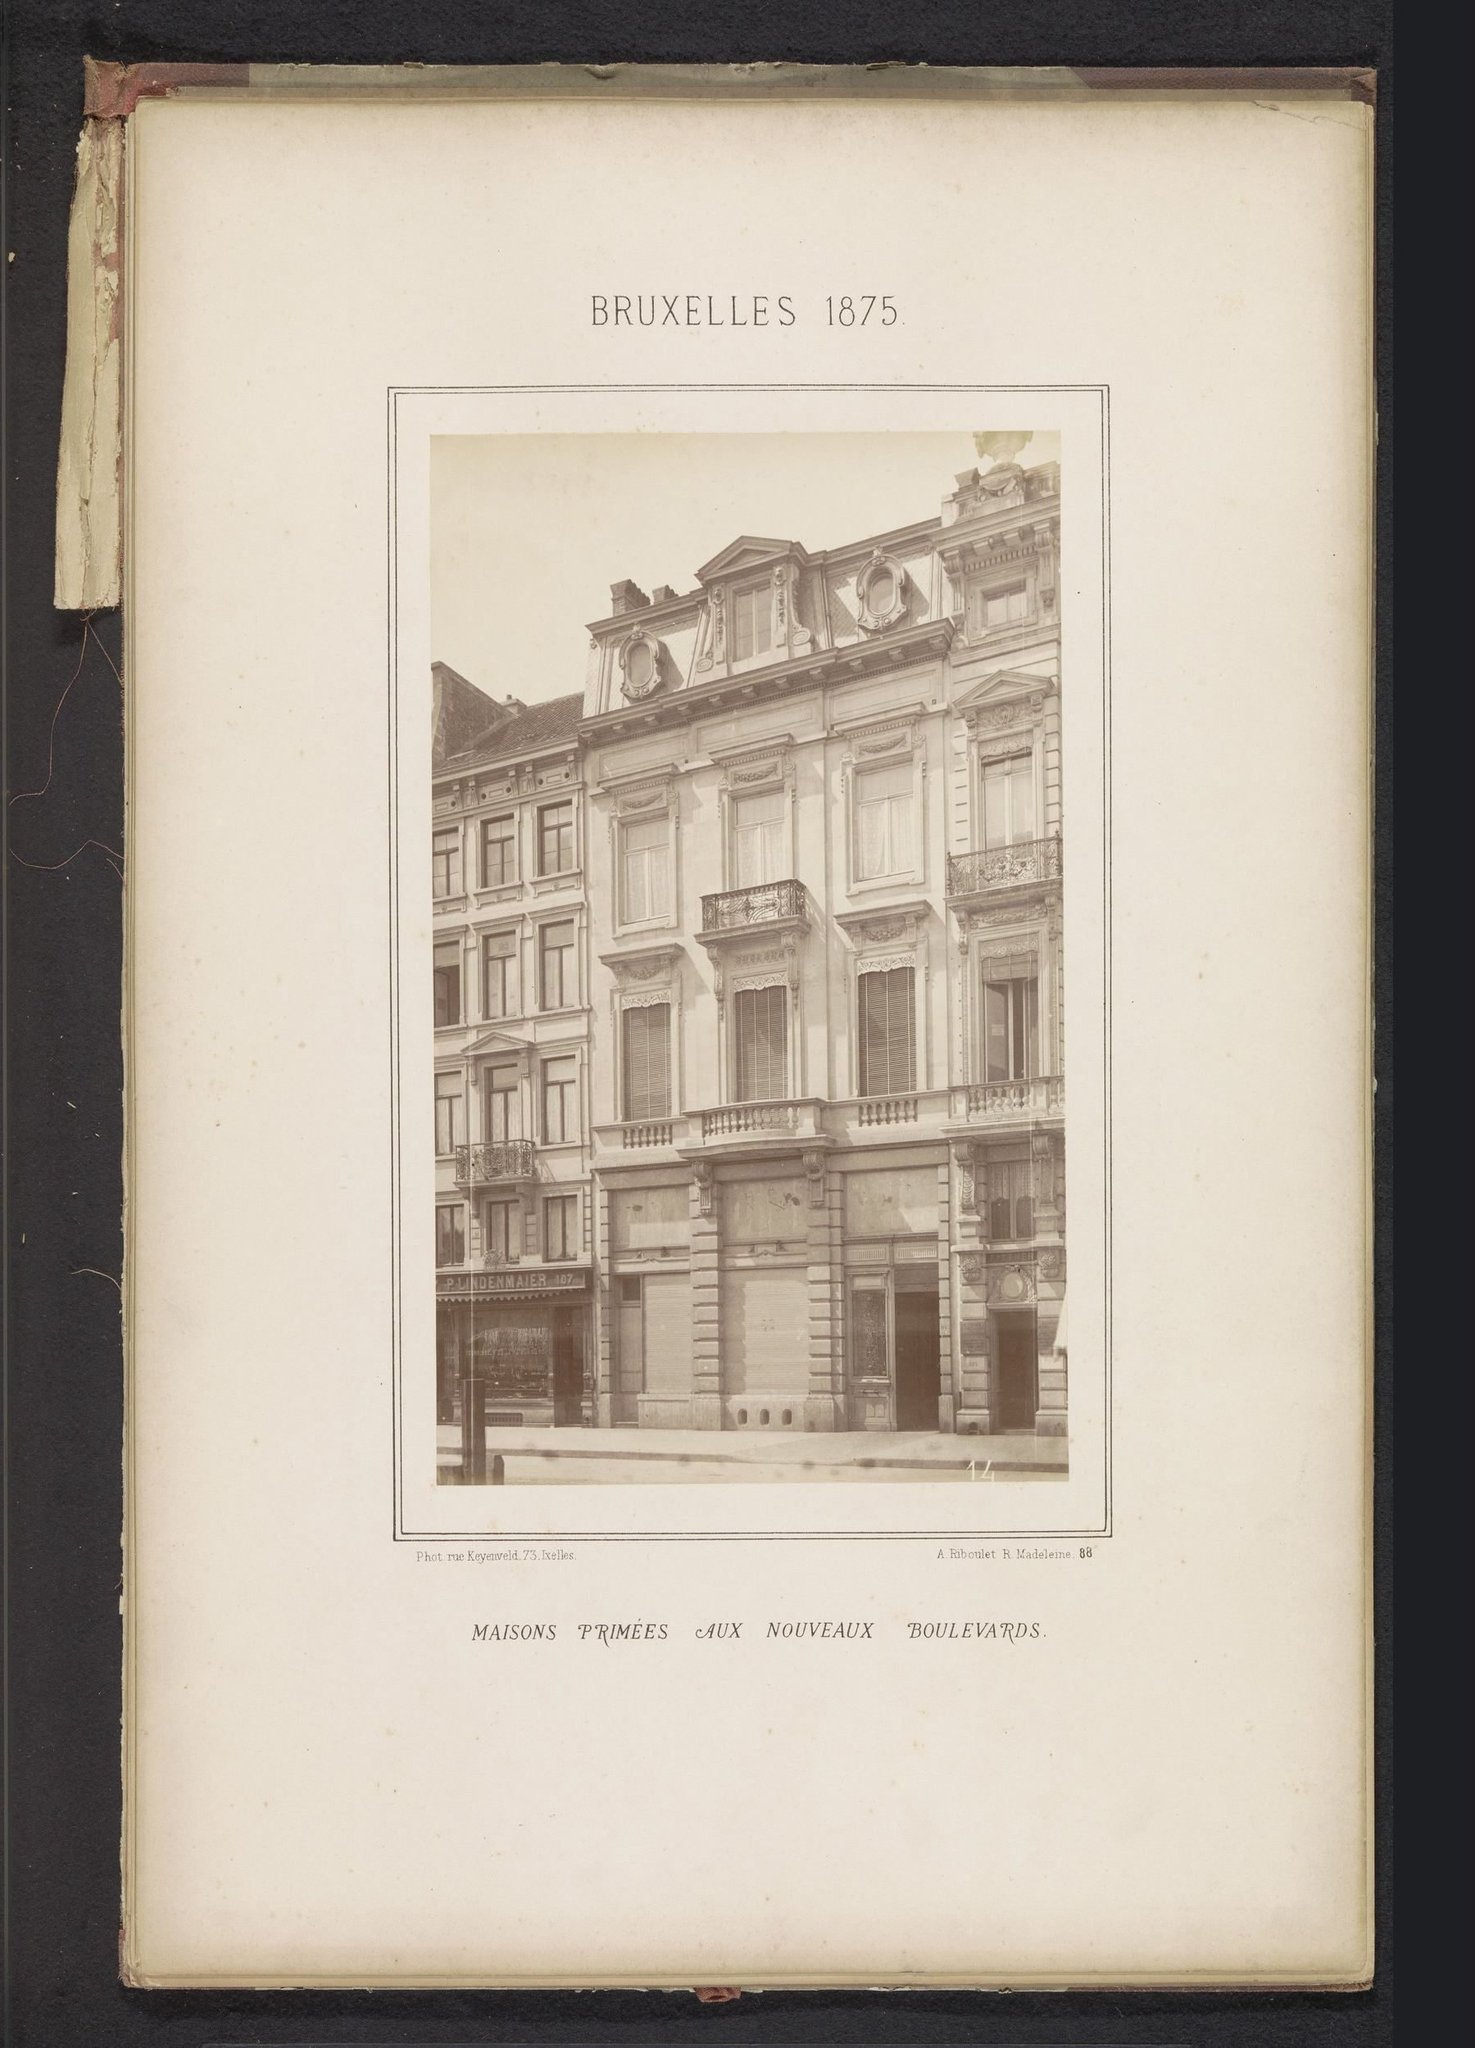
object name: photograph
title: Maisons primées aux nouveaux boulevards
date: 1875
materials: photographic support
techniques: albumen print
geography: brussels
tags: housing, avenue, boulevard, promenade, esplanade, façade (of house or building)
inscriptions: number: ‘14’